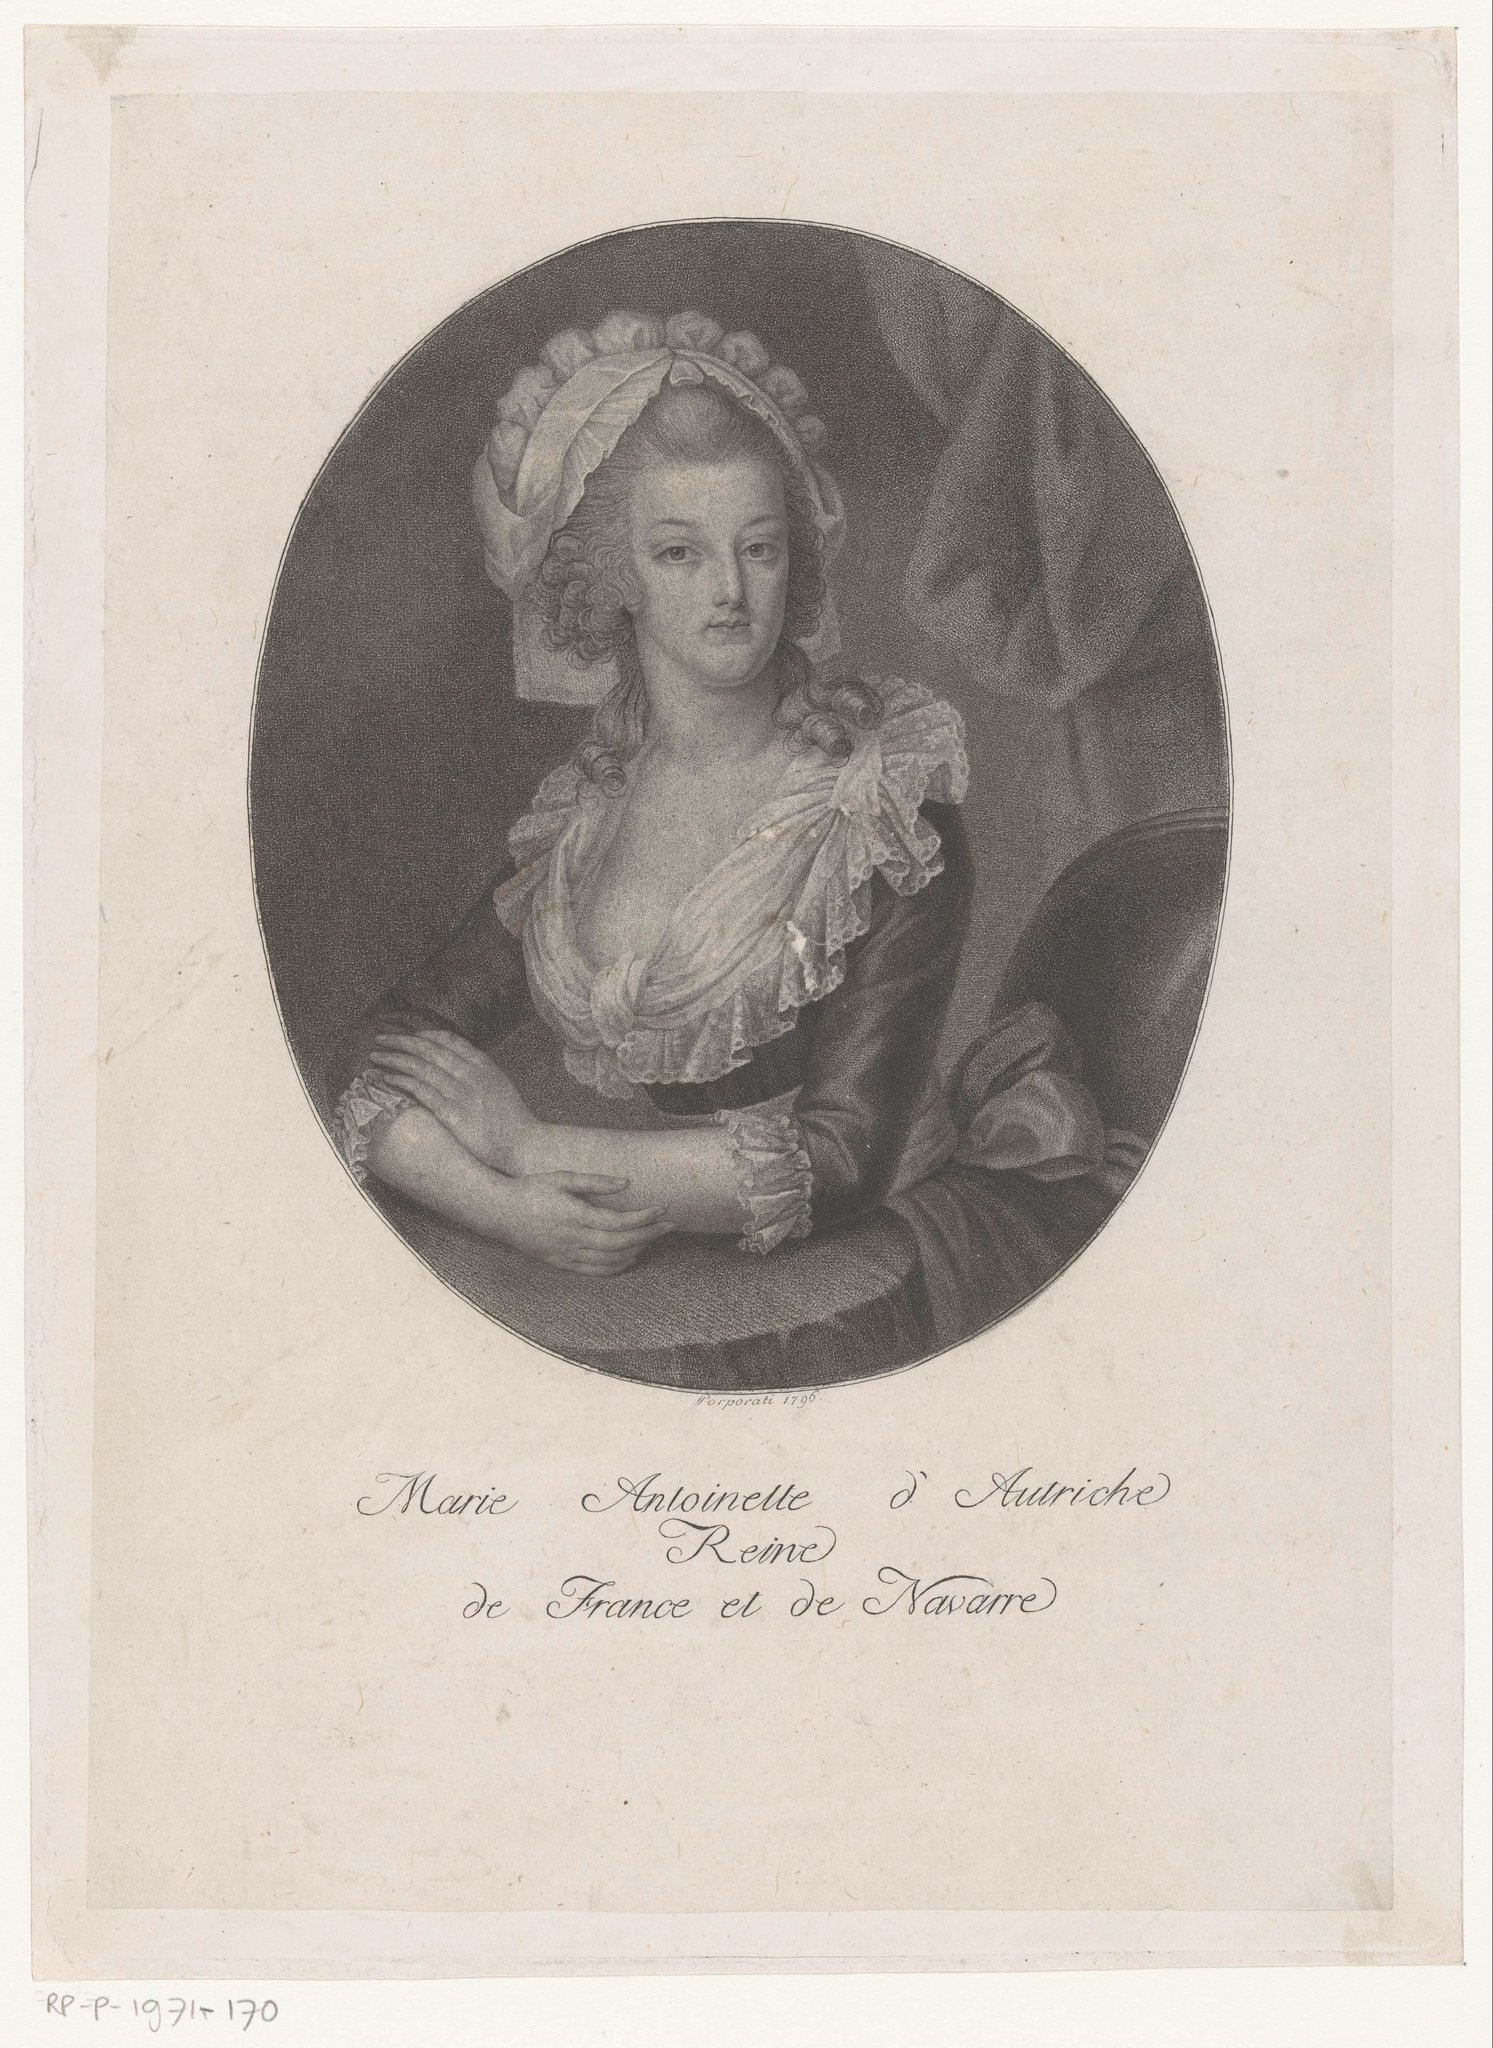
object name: print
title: Portret van Marie Antoinette, koningin van Frankrijk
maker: carlo antonio porporati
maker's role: print maker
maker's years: 1741-1816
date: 1796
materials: paper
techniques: engraving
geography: italy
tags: vienna, paris, marie antoinette, historical persons, ruler, sovereign - bb - female ruler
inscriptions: collector's mark: Lugt 2760, collector's mark: Lugt 2228